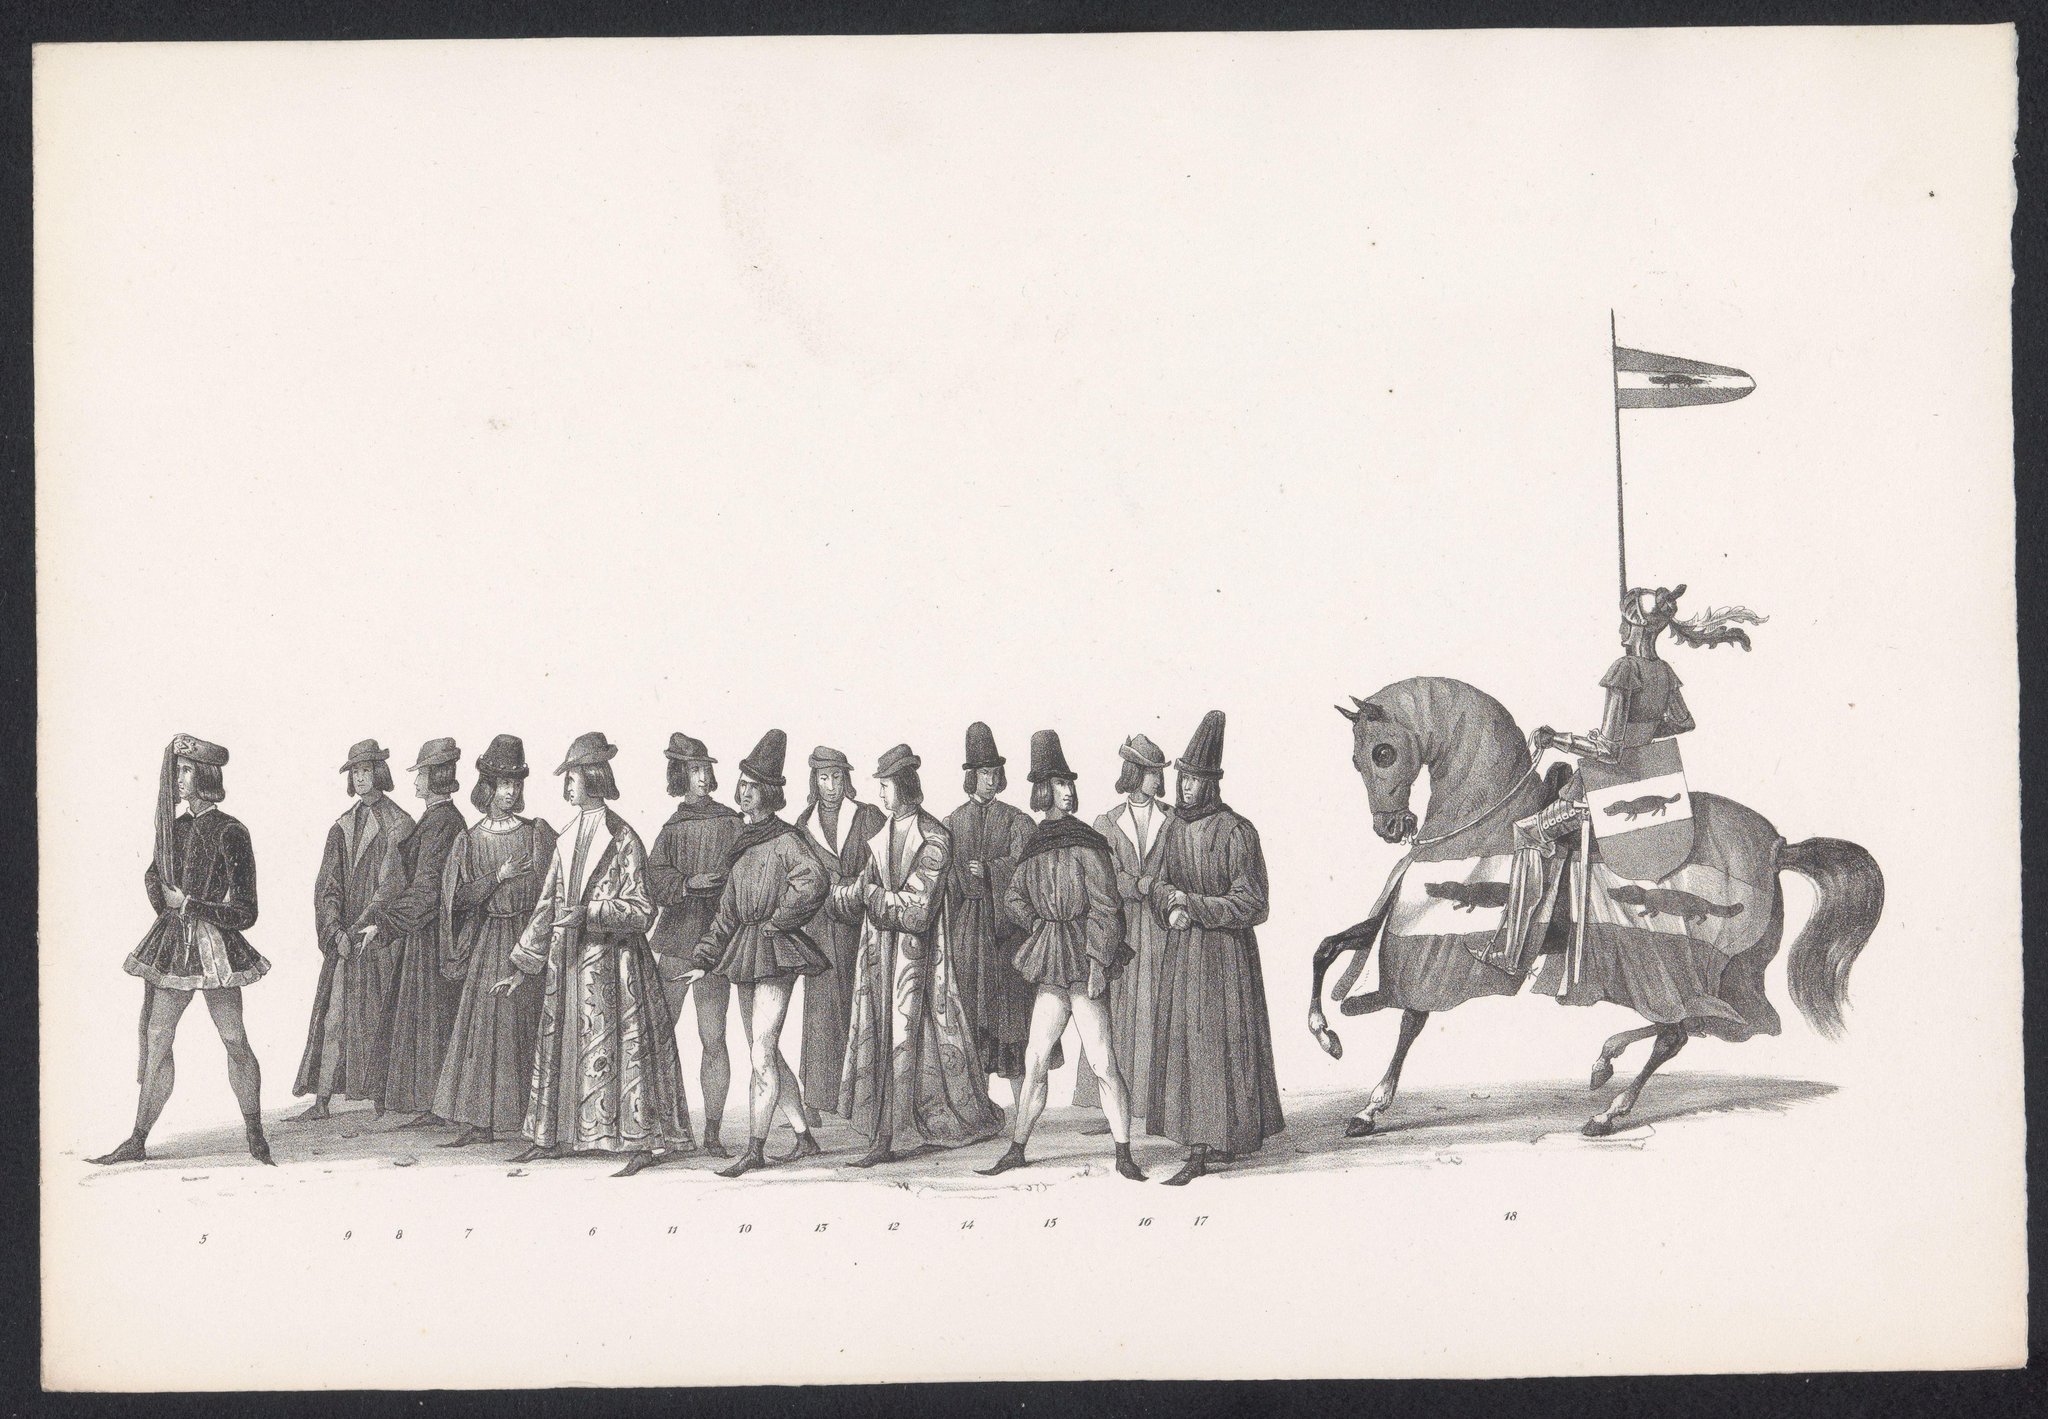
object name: print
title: De intogt van Hertog Jan van Beijeren binnen Leijden, Op den 18den Augustus 1420, in maskerade voorgesteld door H.H. Studenten der Leydsche Hoogeschool, Op den 8sten Februarij 1840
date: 1840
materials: paper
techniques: lithograph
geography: leiden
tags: jan van beieren, students' pageant, costumes used in pageants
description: Historische gekostumeerde optocht van de studenten van de Hogeschool van Leiden op 8 februari 1840. De optocht verbeeldt de intocht van hertog Jan van Beieren te Leiden op 18 augustus 1420. Derde plaat in een serie van negentien ongenummerde platen, met de groepen genummerd 5-18.